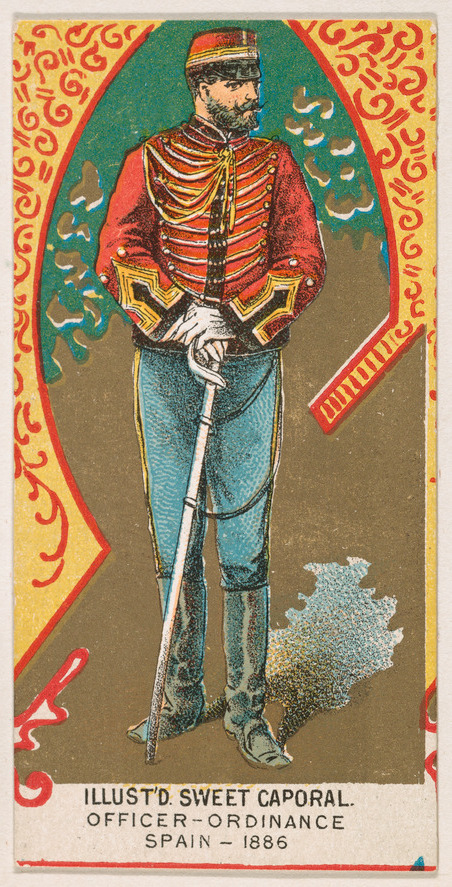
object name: print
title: Officer, Ordinance, Spain, 1886, from the Military Series (N224) issued by Kinney Tobacco Company to promote Sweet Caporal Cigarettes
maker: kinney brothers tobacco company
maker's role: publisher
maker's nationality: american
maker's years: 1869-2011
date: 1888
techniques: color lithograph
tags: military,swords,men